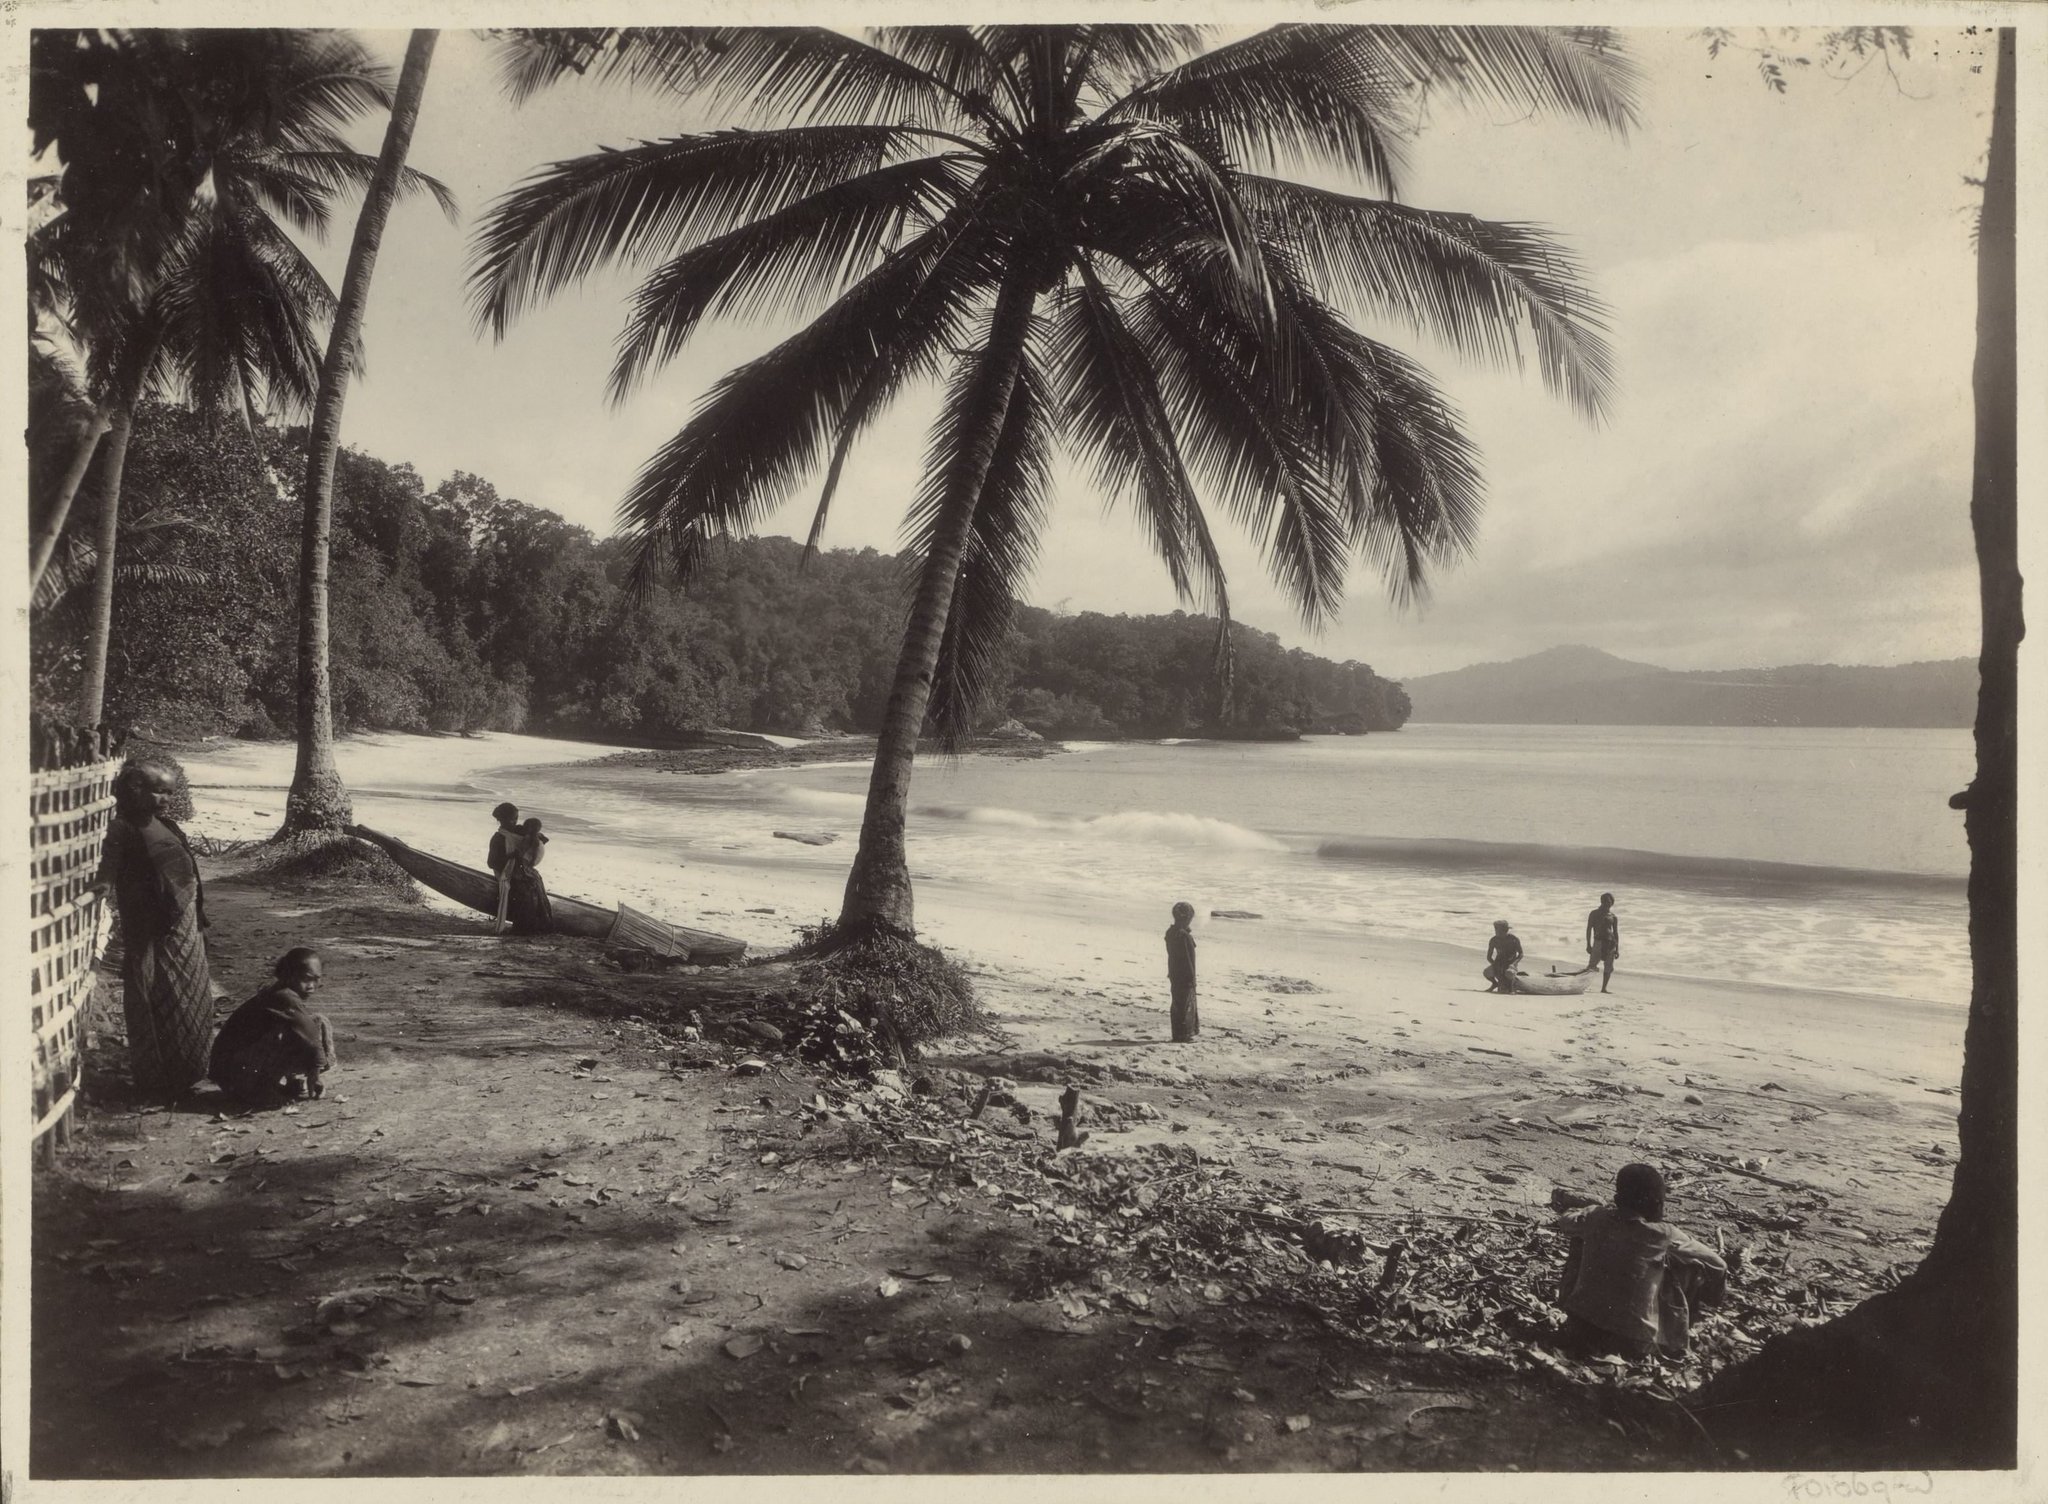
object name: photograph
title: Strandgezicht in Nederlands-Indië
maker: onnes kurkdjian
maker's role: fotograaf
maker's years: 1851-1903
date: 1912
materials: paper, photographic support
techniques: gelatin silver print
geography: dutch east indies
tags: trees: palm-tree, beach, dutch east indies, the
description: Onderdeel van Reisalbum met veertig foto's van Nederlands-Indië.